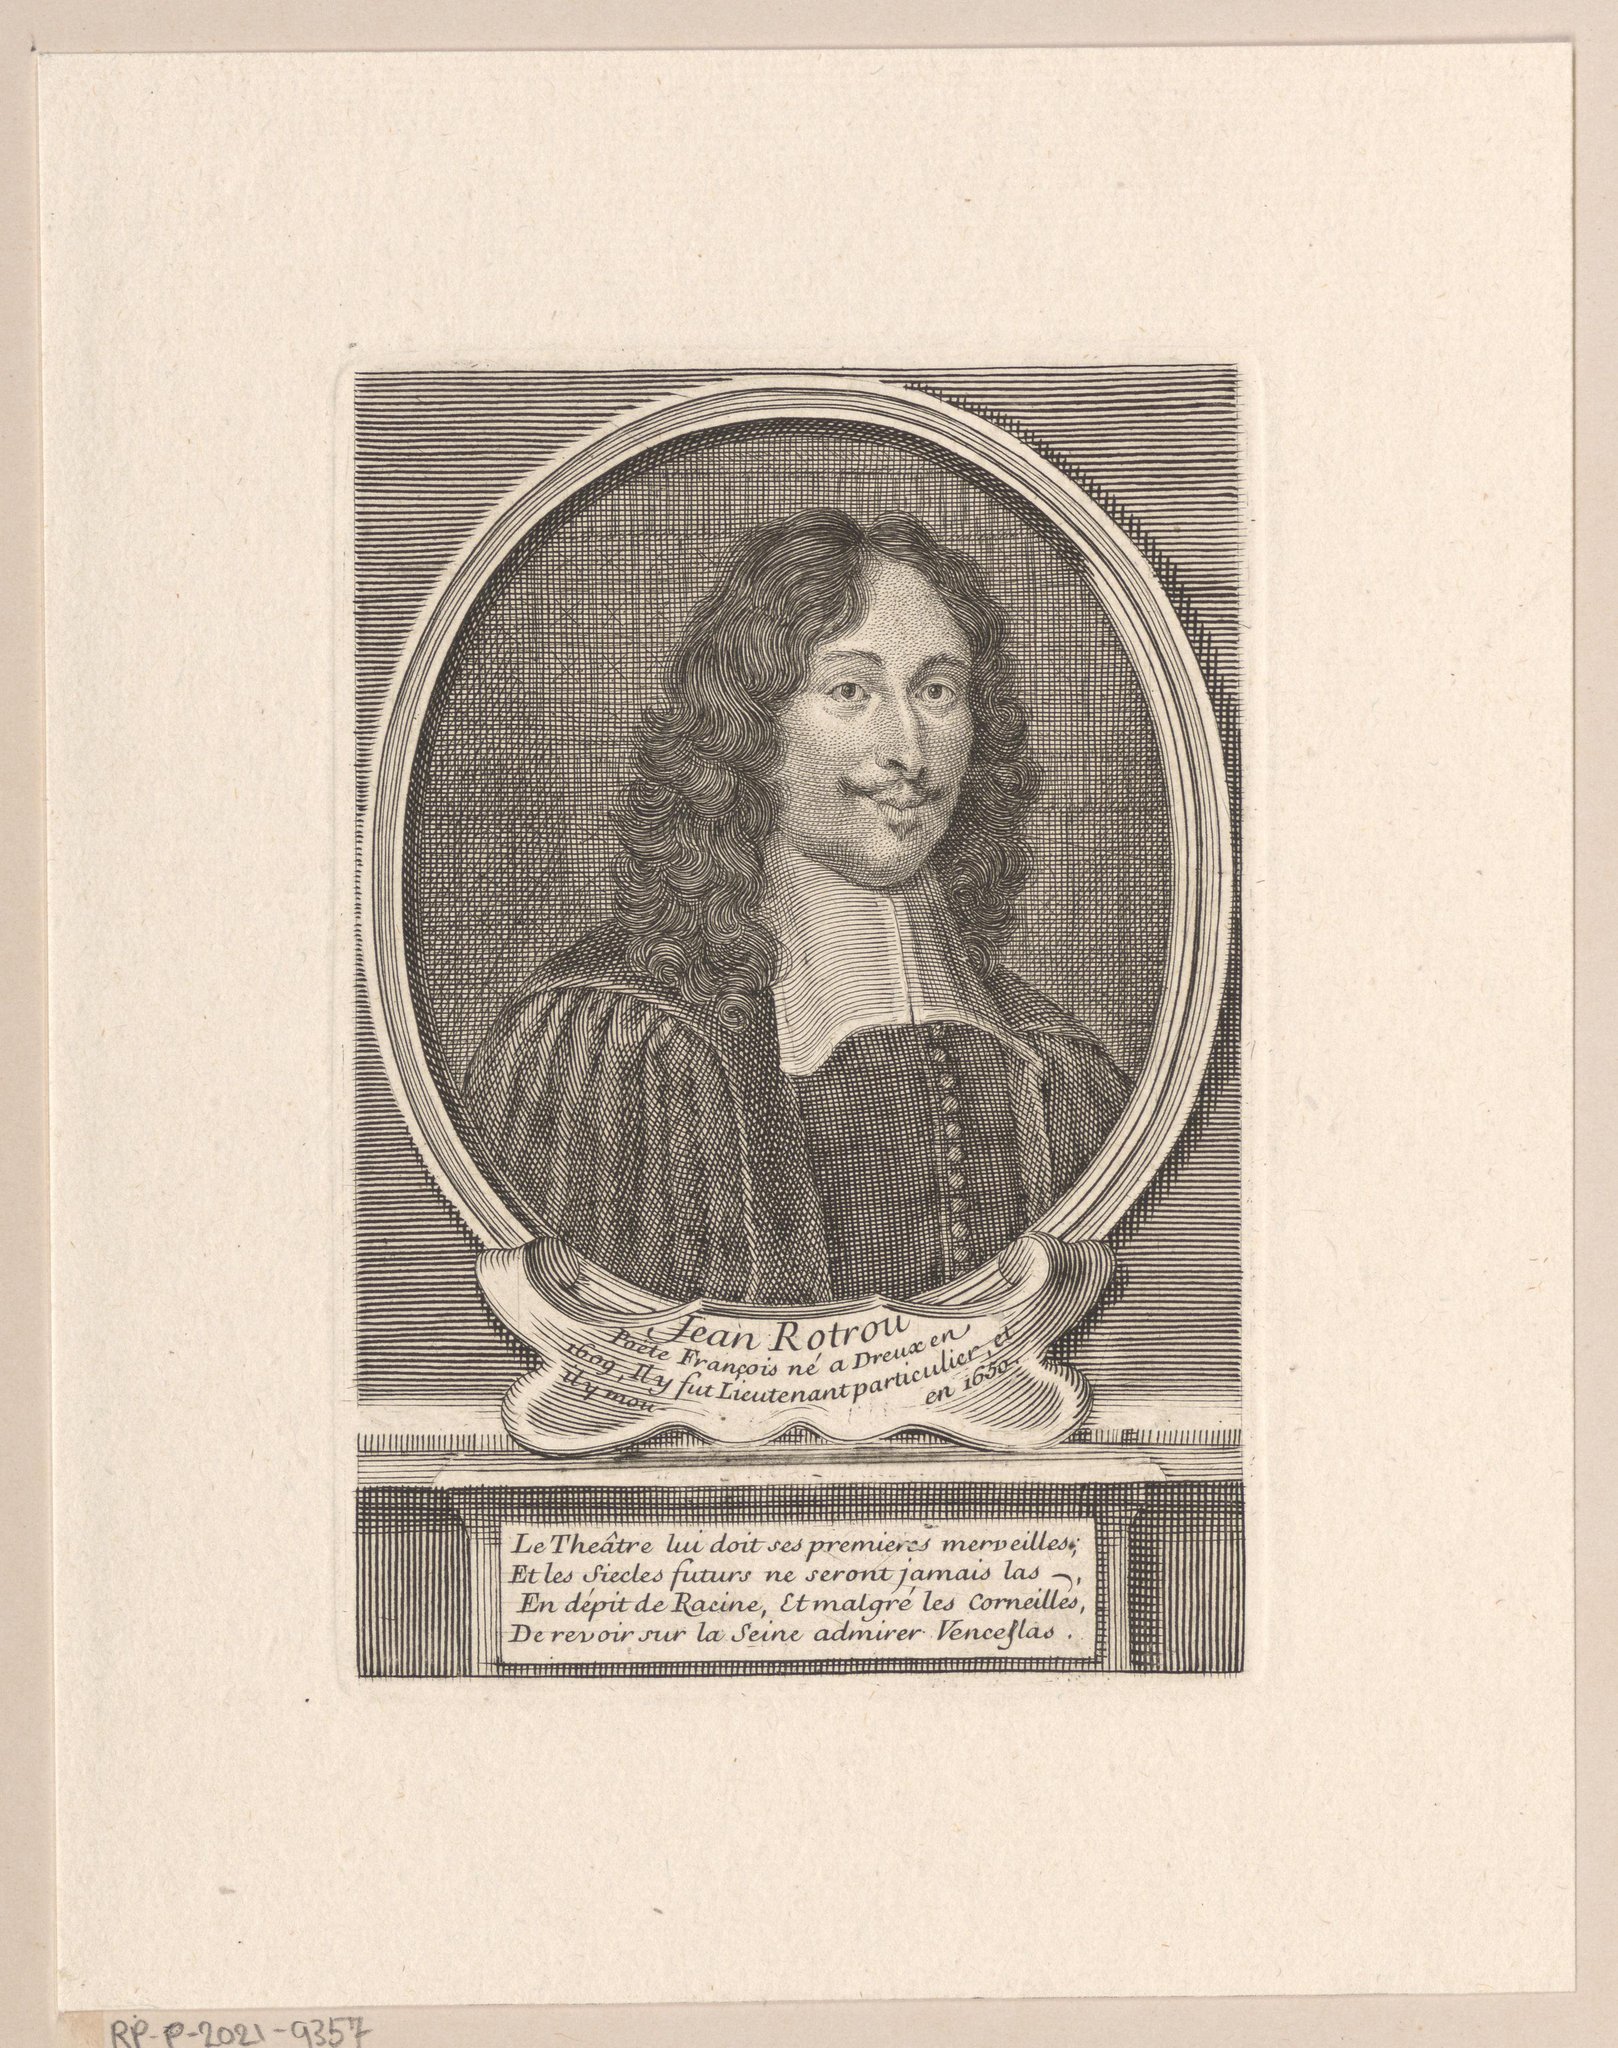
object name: print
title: Portret van Jean Rotrou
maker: Anonymous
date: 1650-1749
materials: paper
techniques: engraving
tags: historical persons